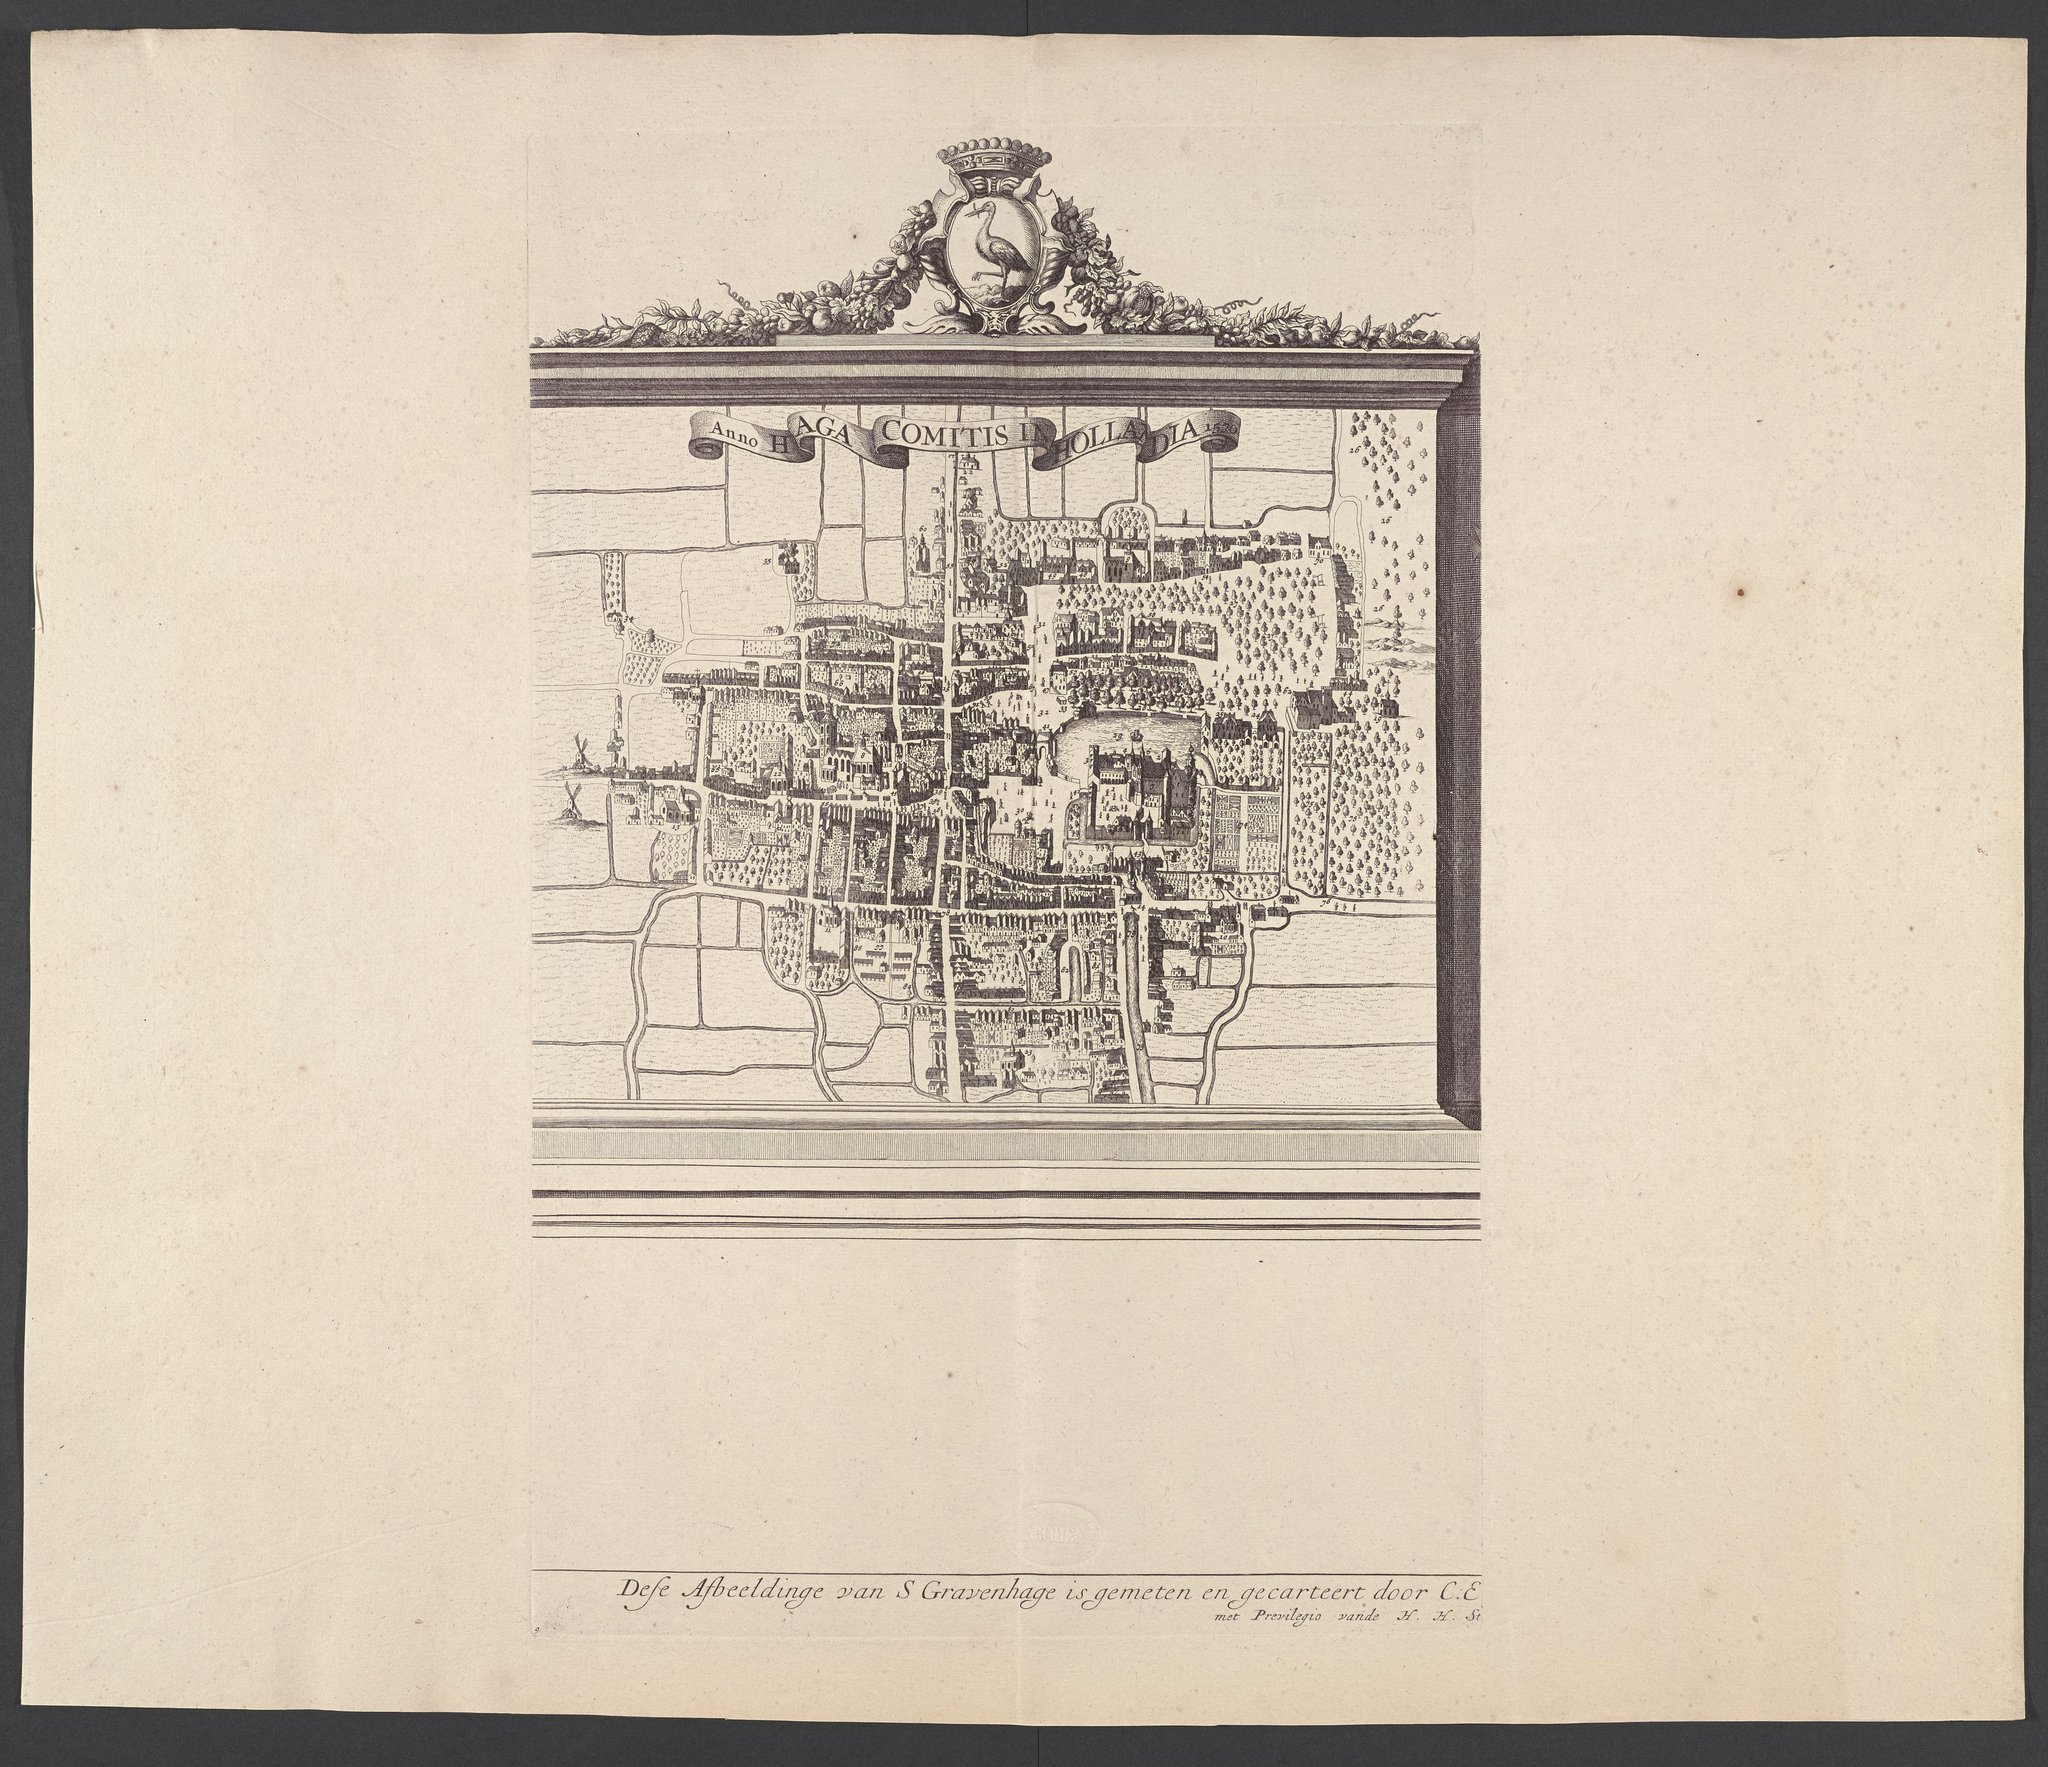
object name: print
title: Anno Haga Comitis in Hollandia 1570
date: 1665-1667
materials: paper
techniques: etching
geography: the hague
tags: coat of arms (as symbol of the state, etc.) (+ city; municipal), maps of cities, the hague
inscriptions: collector's mark: Lugt 2228, check stamp: ‘Archief Ministerie van Oorlog Afdeeling Genie’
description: Deze prent is onderdeel van een plattegrond van Den Haag. Deze staat van de plattegrond werd oorspronkelijk uitgegeven met een sierrand, bestaande uit een gezicht op de stad en veertien kleinere gezichten in en om Den Haag, en vormde zo de zogenaamde figuratieve kaart van Den Haag. Voor de prenten die de rand vormen, zie: RP-P-AO-12-8, RP-P-AO-12-8-2, RP-P-OB-50.201, RP-P-OB-50.202, RP-P-OB-50.203, RP-P-OB-50.204, RP-P-OB-50.205, RP-P-OB-50.206, RP-P-OB-50.207, RP-P-OB-50.208, RP-P-OB-102.387, RP-P-OB-50.209, RP-P-OB-50.210, RP-P-OB-50.211, RP-P-OB-50.212, RP-P-OB-50.213, RP-P-AO-12-5-4 en RP-P-OB-50.214.